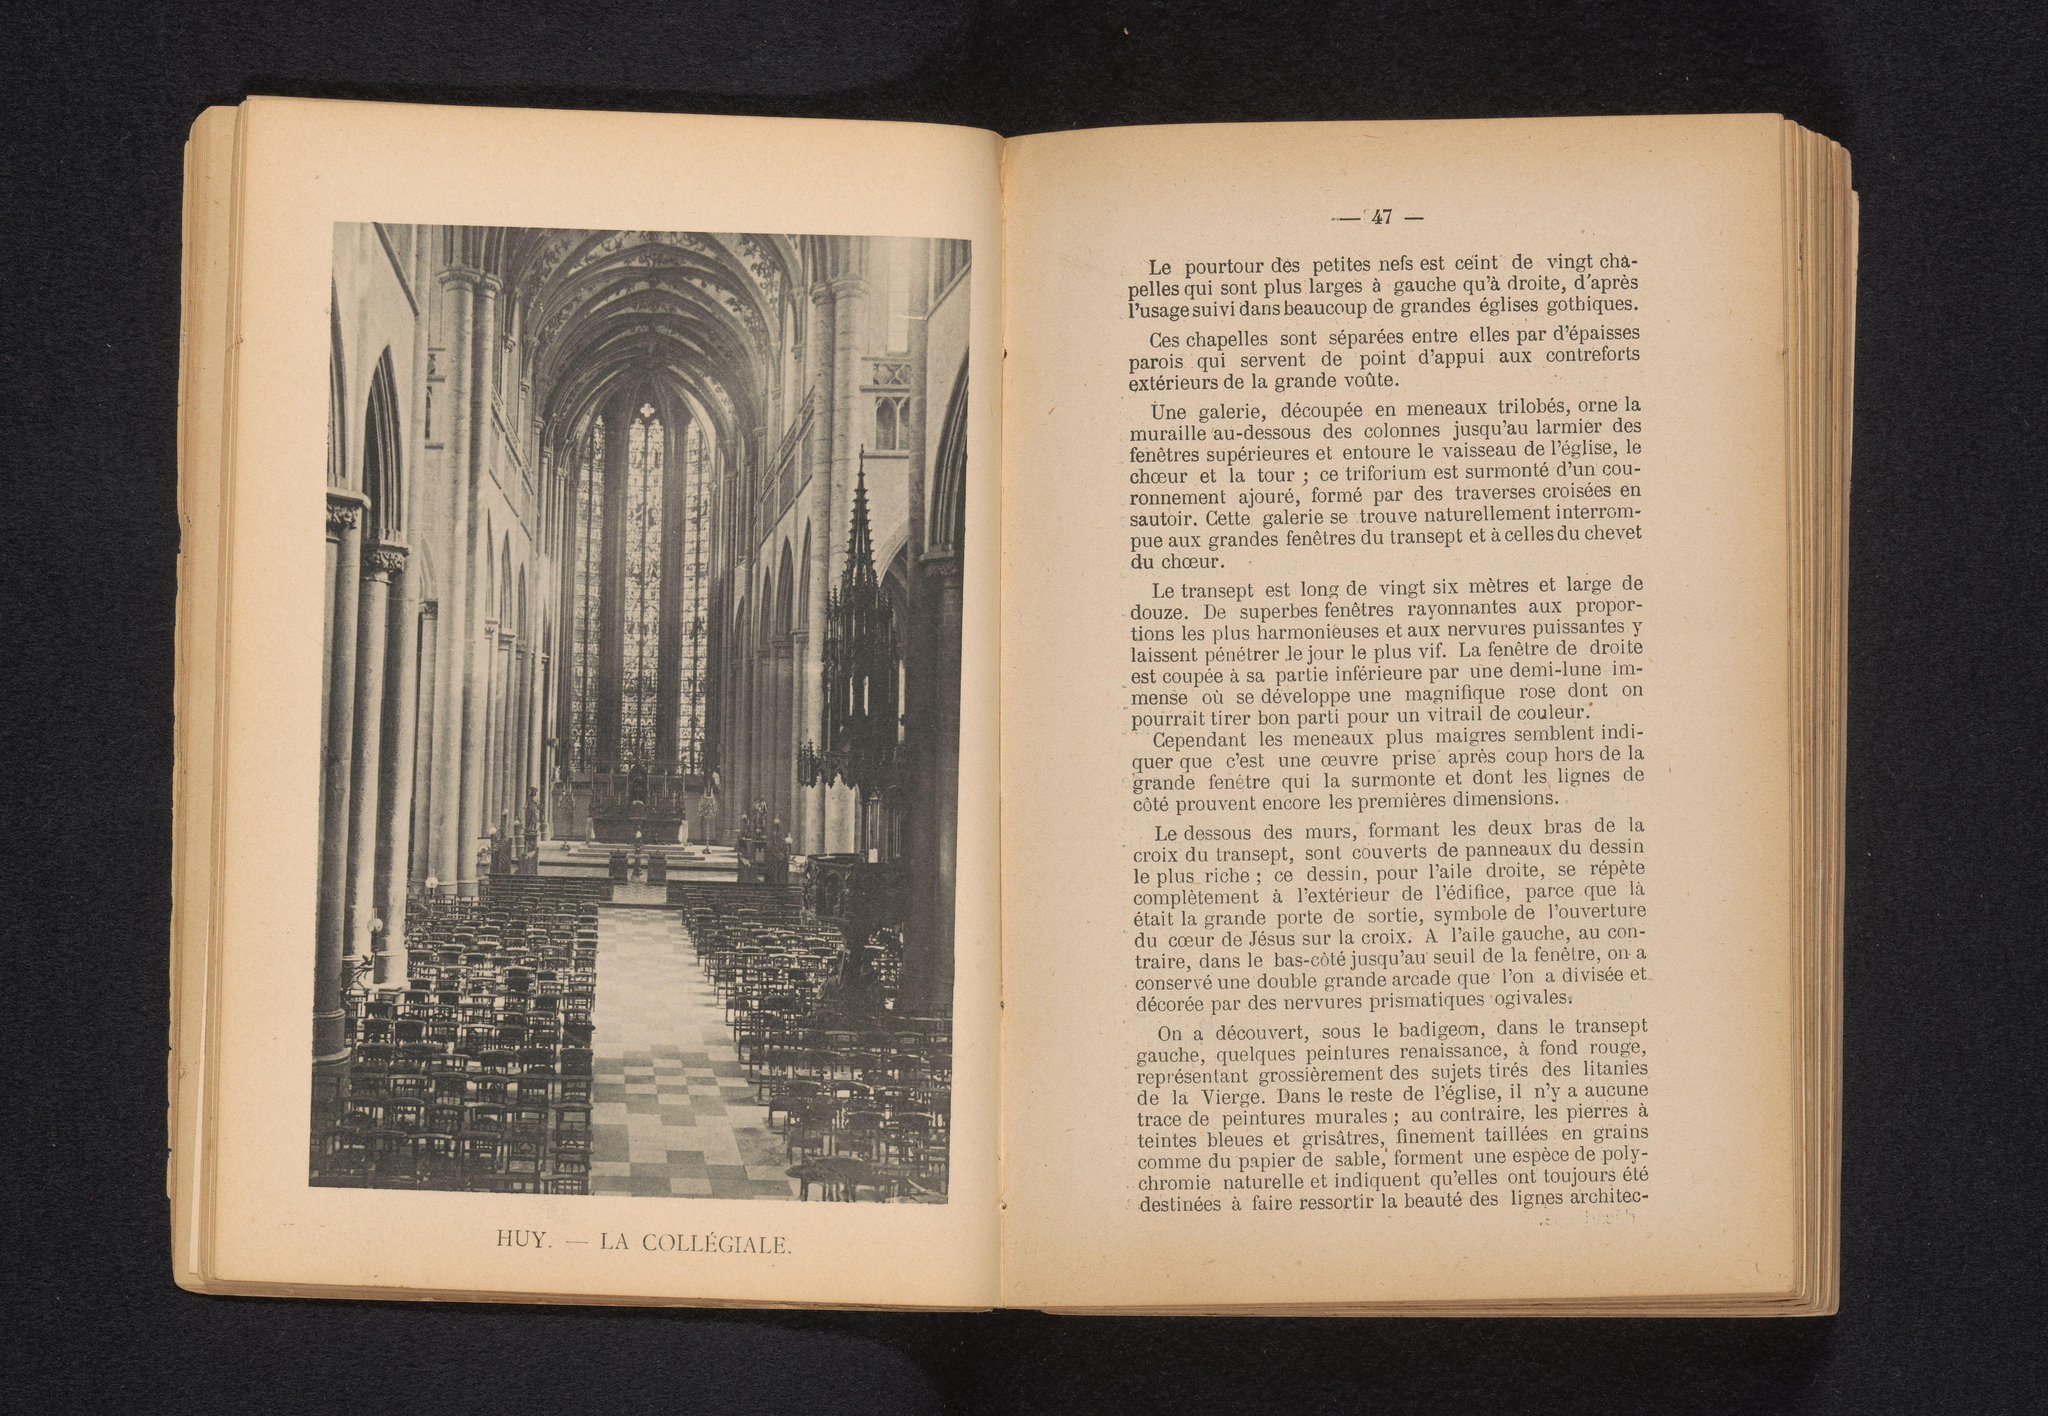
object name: page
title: Huy. La Collégiale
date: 1885-1890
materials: paper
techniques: photograph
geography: hoei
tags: interior of church